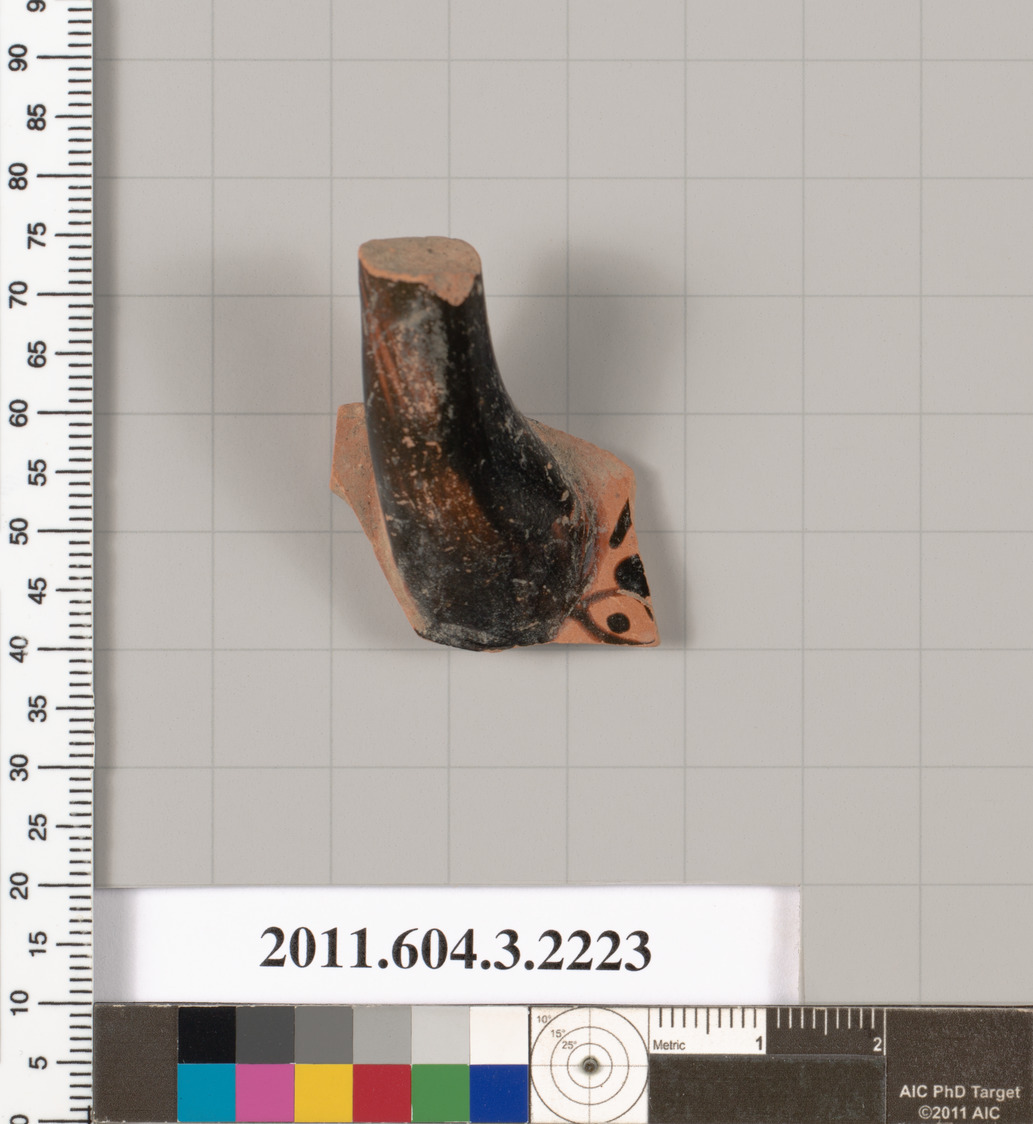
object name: kylix fragment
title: Terracotta fragment of a kylix (drinking cup)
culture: greek, attic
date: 525-501 BCE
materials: terracotta